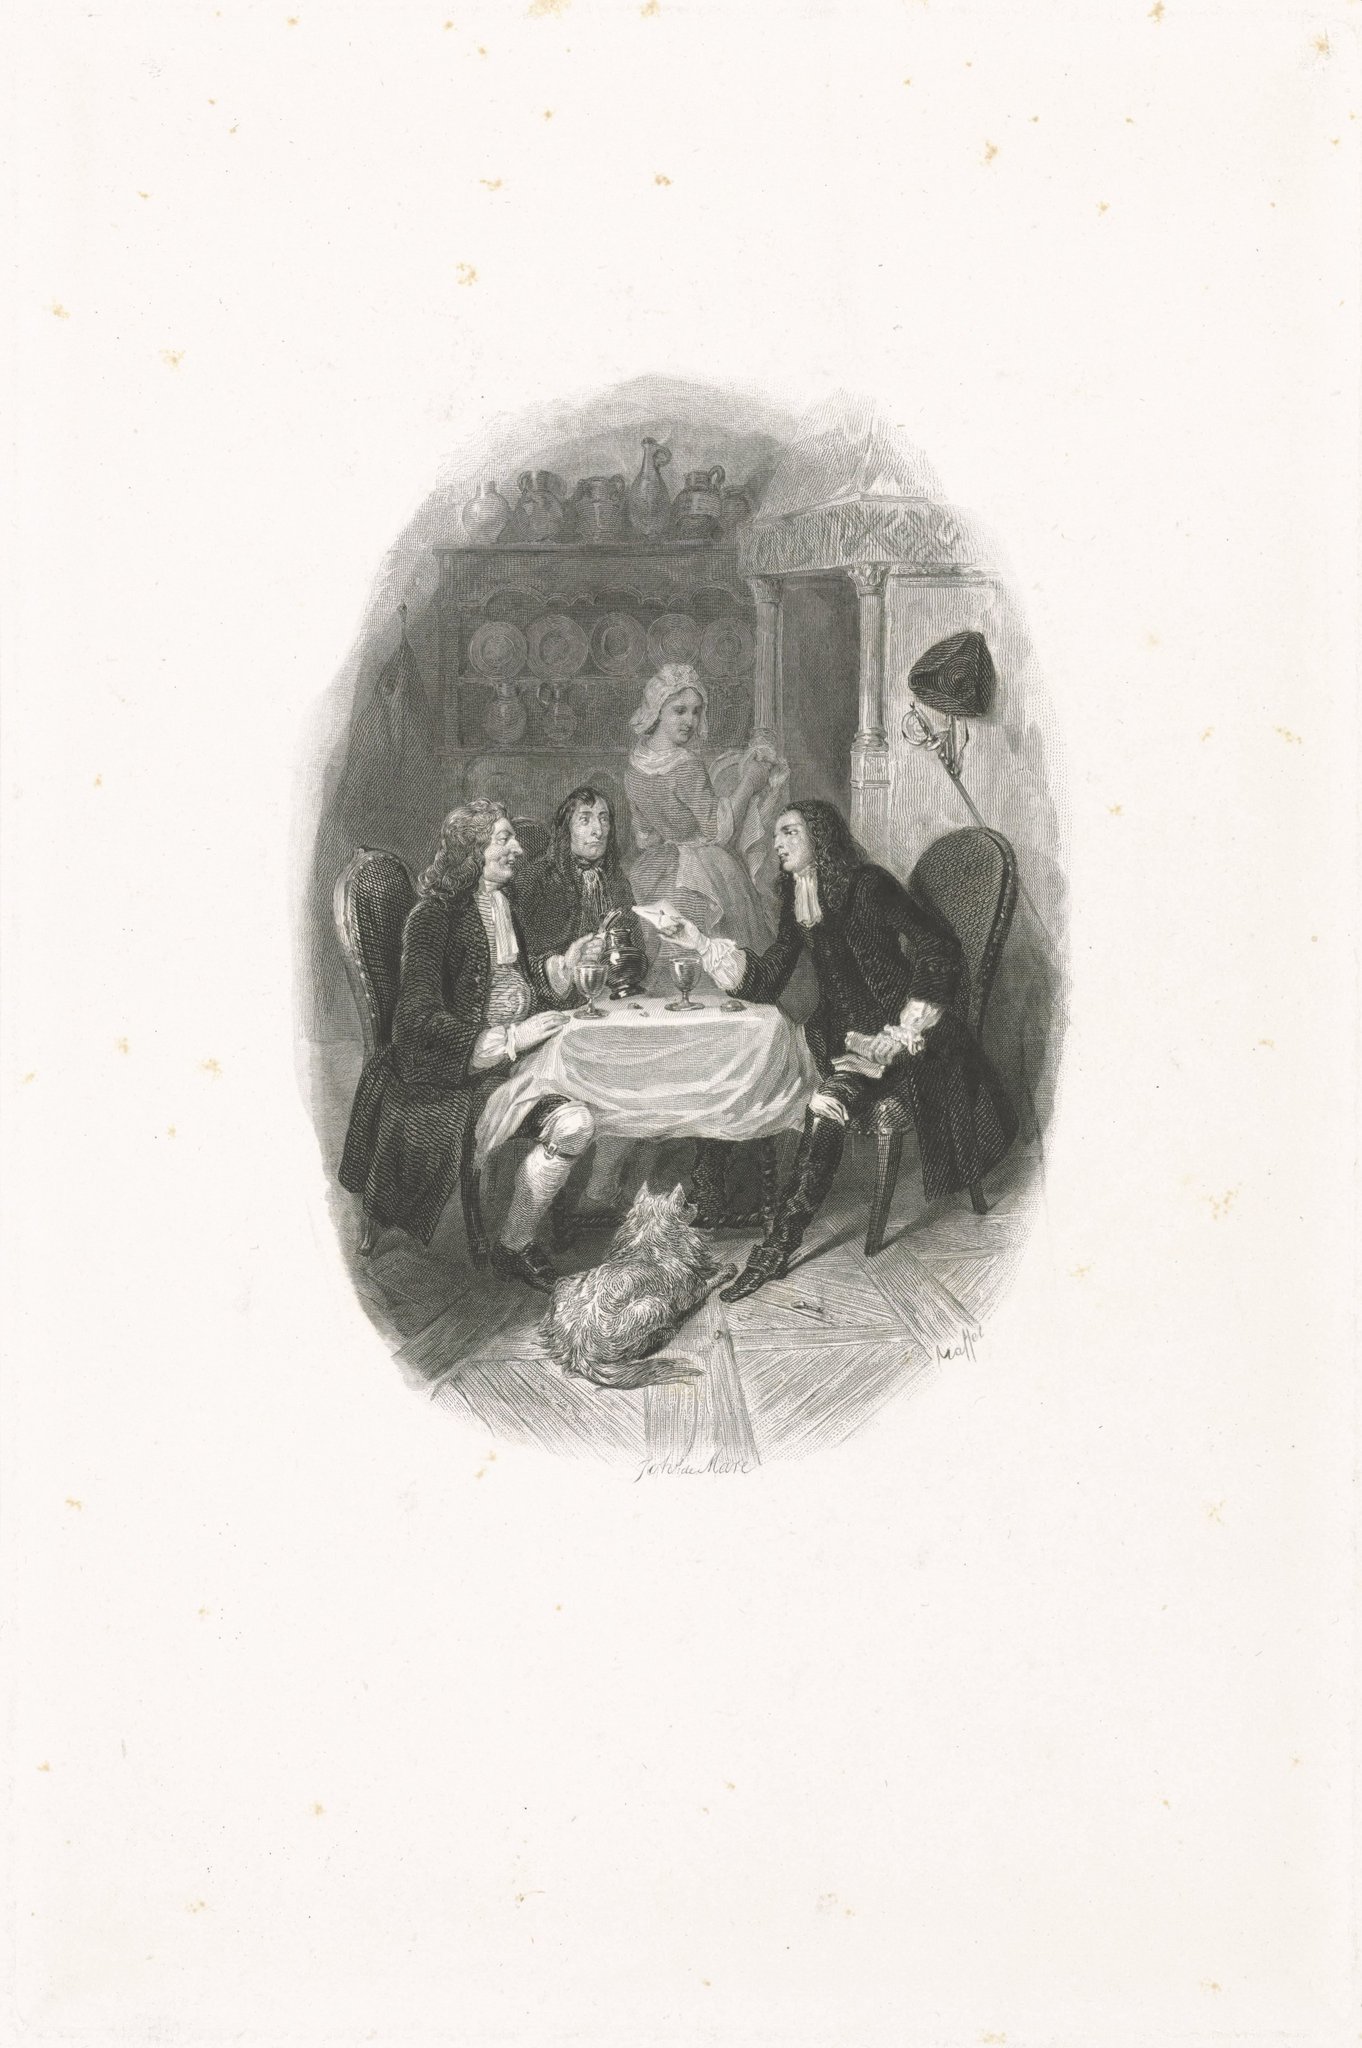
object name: print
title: Drie mannen aan een tafel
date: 1816-1889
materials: paper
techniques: engraving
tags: table, kitchen-interior, letter, envelope, kitchen-maid, kitchen servant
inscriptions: collector's mark: Lugt 2228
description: Drie mannen aan een tafel in een keukeninterieur, een van hen met een brief in zijn hand. Op de achtergrond een dienstmeid.